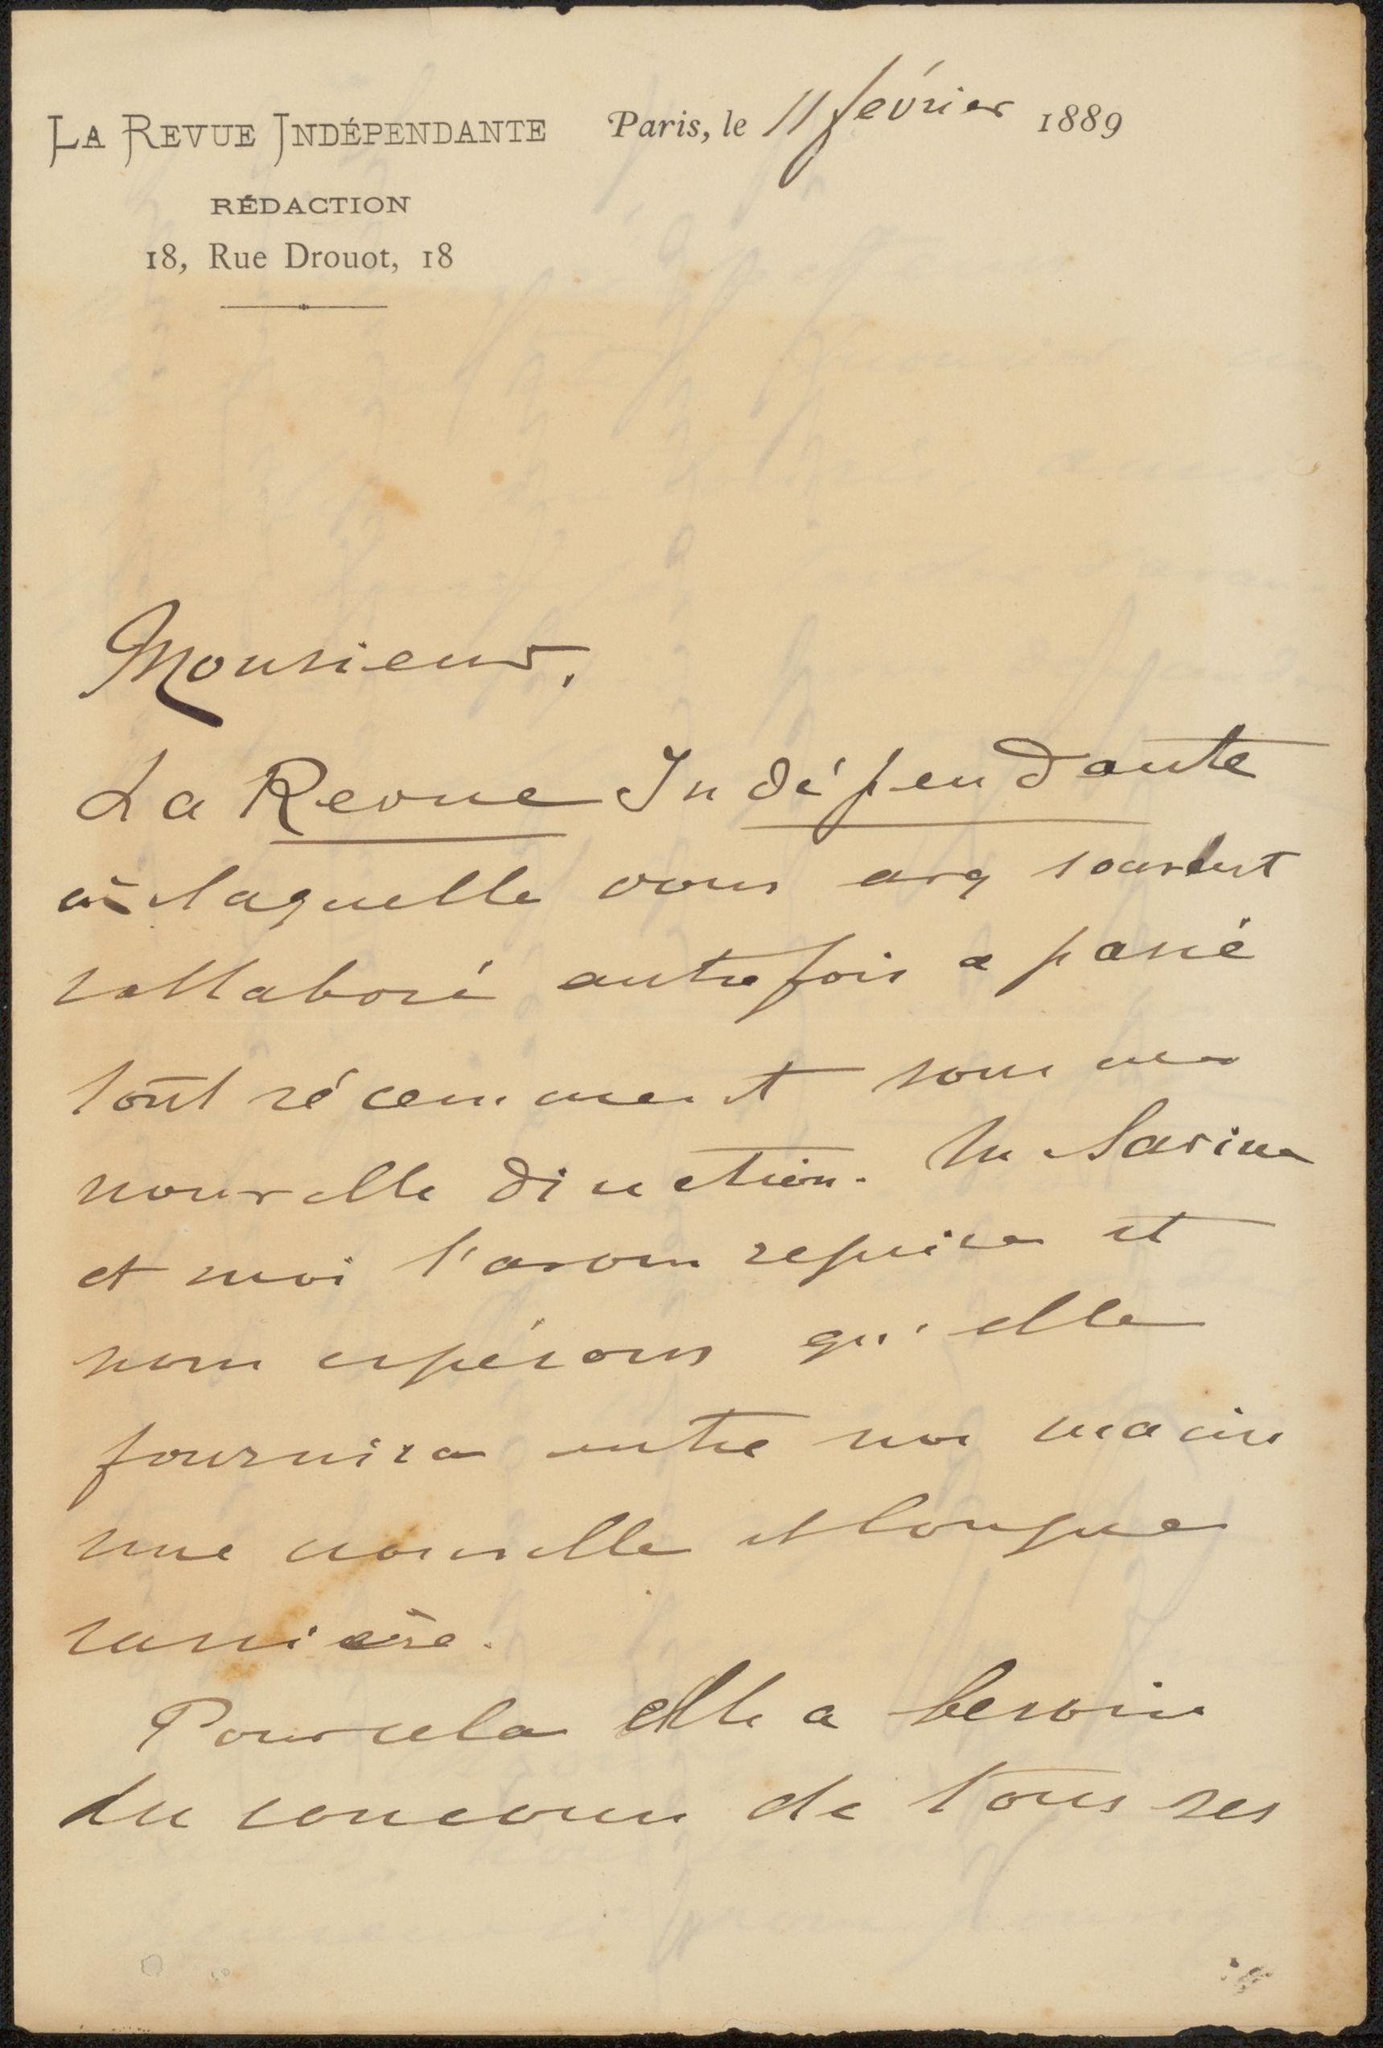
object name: letter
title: Brief aan Philip Zilcken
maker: françois de nion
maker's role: schrijver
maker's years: 1856-1923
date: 1889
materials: ink, paper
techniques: pen, printing, writing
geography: paris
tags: the hague, painter, draughtsman, philip zilcken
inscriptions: collector's mark: ‘RPK’, watermark